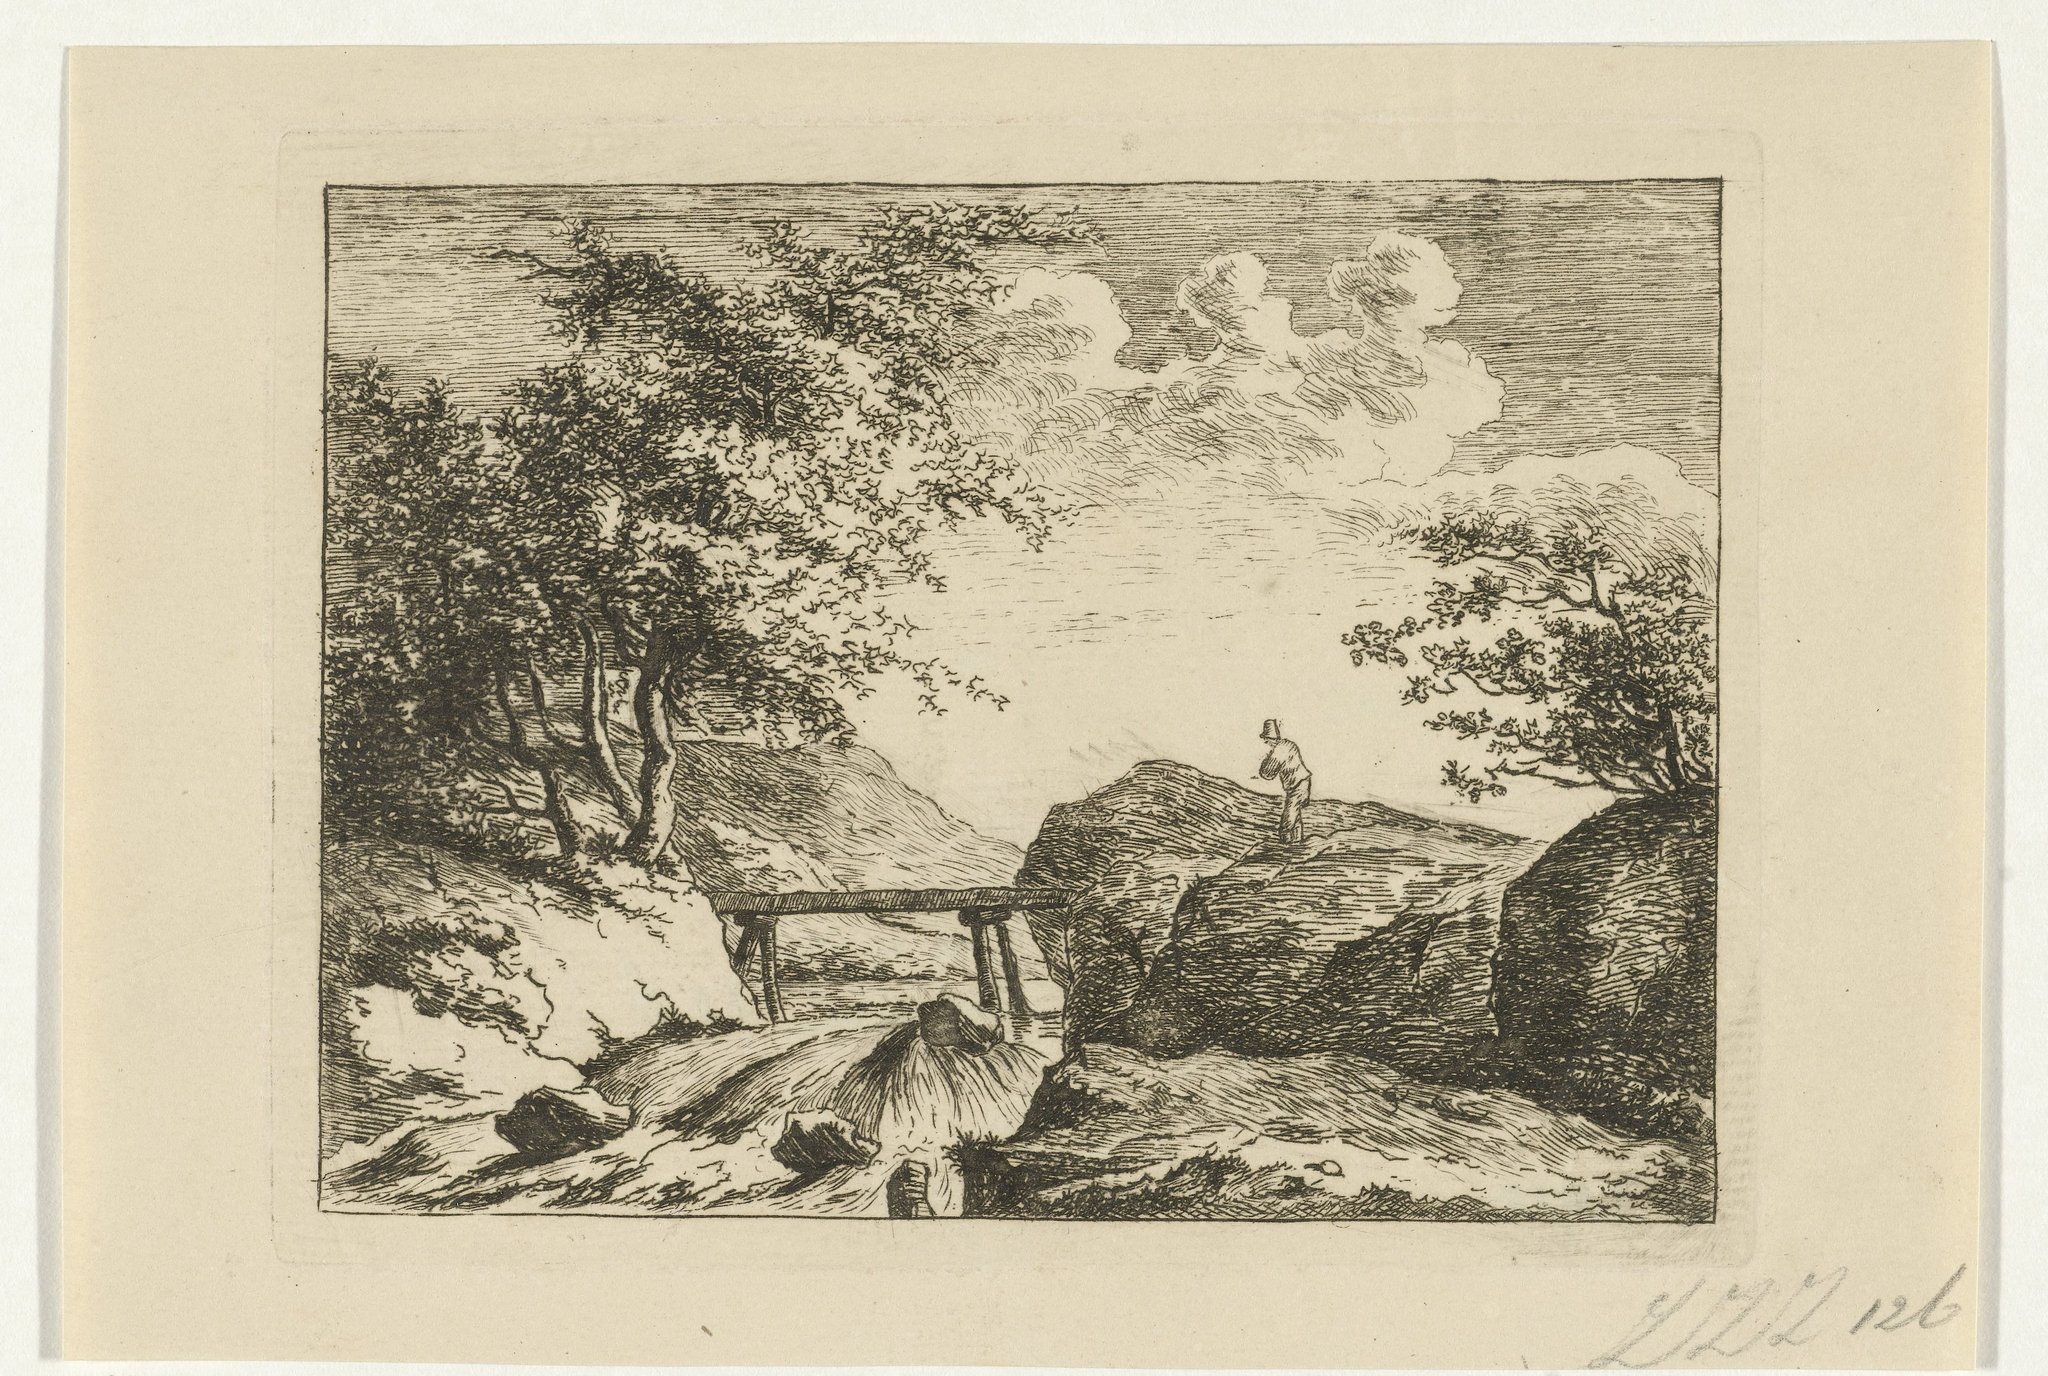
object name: print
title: Brug bij een waterval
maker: reinierus albertus ludovicus baron van isendoorn à blois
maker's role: print maker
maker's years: 1786-1856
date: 1796-1856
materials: paper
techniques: etching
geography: vaassen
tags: waterfall, bridge, landscapes (+ landscape with figures, staffage)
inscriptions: collector's mark: Lugt 2228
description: Een brug over een waterval. Rechts staat een man op een rots.